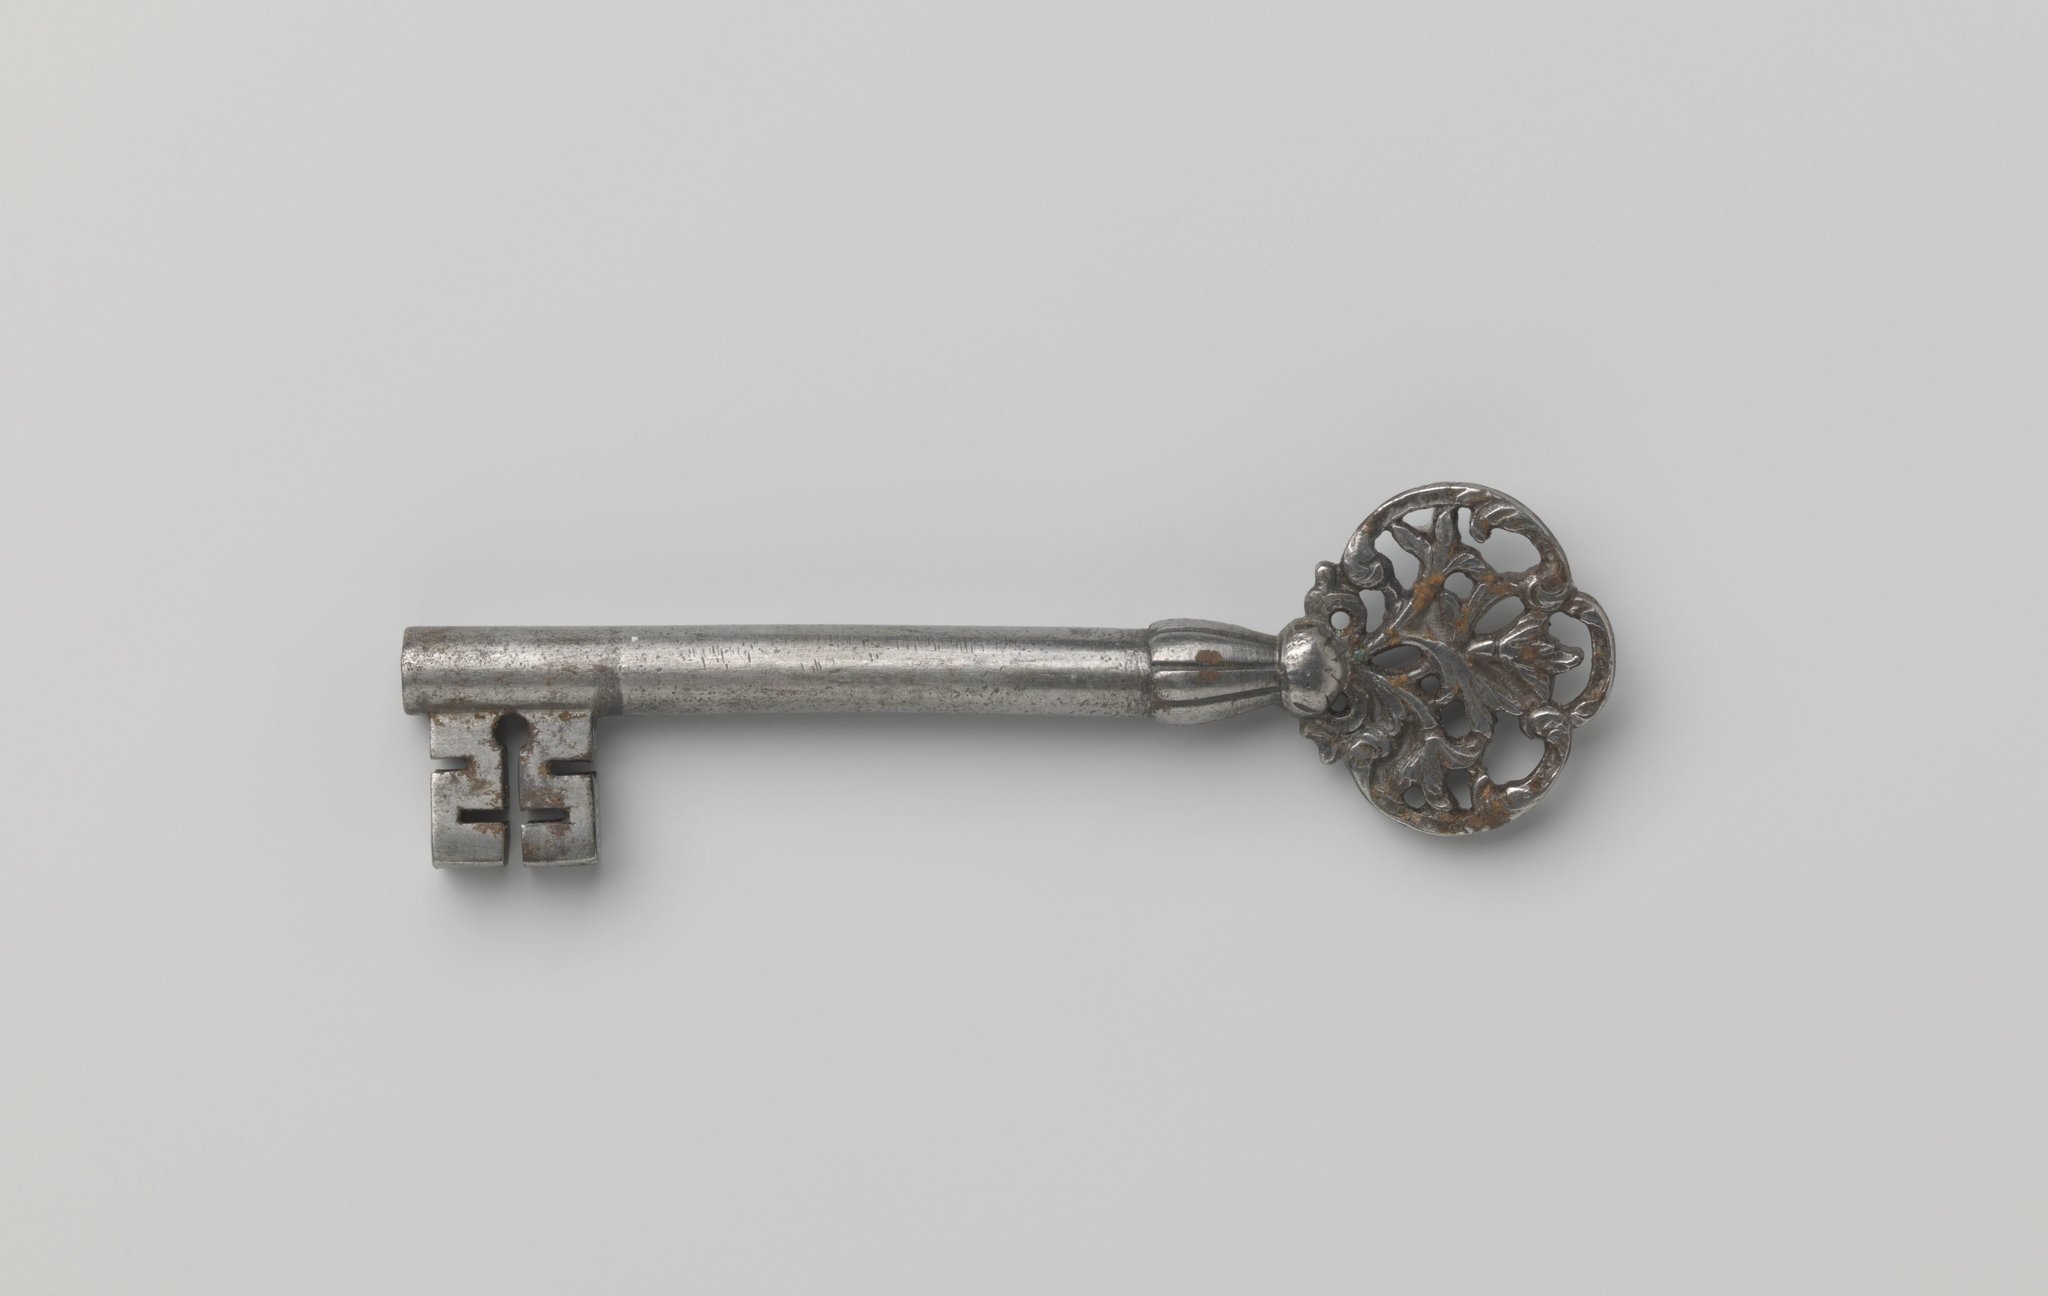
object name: key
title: Sleutel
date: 1700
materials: iron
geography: germany